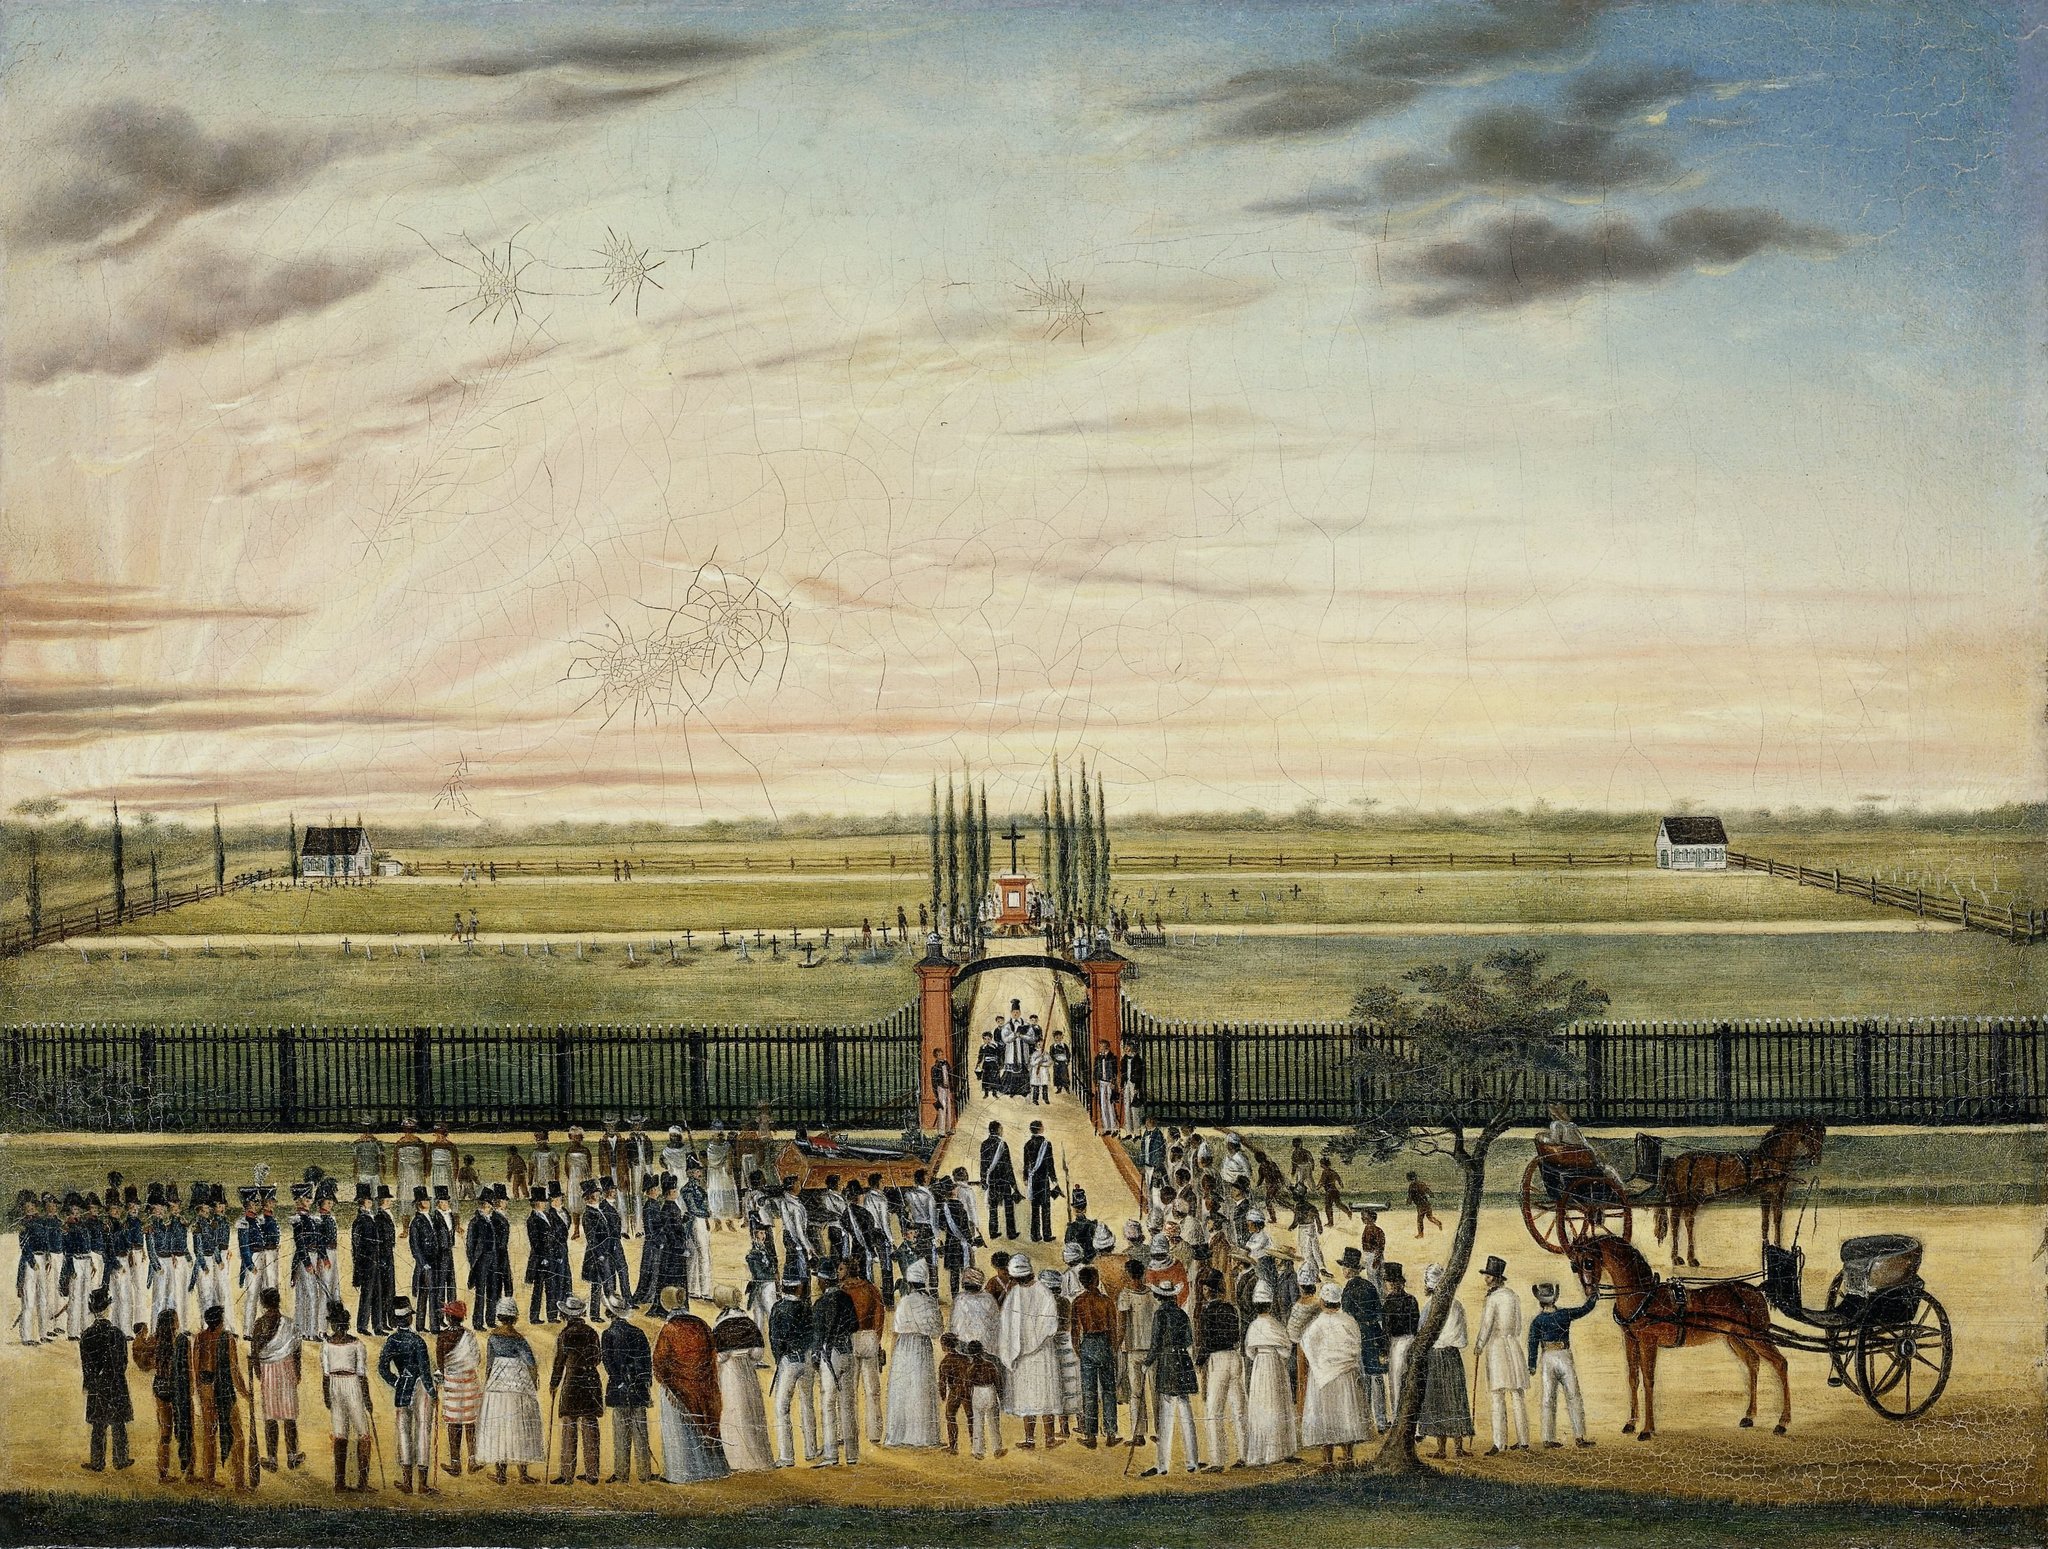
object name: painting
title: The Burial of Father Joannes Vitus Janssen (1803-43) at Paramaribo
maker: Anonymous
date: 1843-1845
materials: canvas, oil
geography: northern netherlands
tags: priest, batavia, missionary, amsterdam, cortege, funeral procession, public funeral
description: Funeral in Paramaribo of the missionary Joannes Vitus Janssen, 1843. Anonymous, c. 1843. The coffin is borne by twelve black pall bearers dressed in white to symbolise mourning. Two priests walk behind the coffin: Petrus Donders, known as the 'apostle of the Indians and lepers of Surinam', and T. Kempkes. They are followed by the church councillors, the governor's staff and various officers. Around 1,400 black Surinamers, all Catholic converts, attended the funeral. In the foreground, left, is an Indian family. Preceding the coffin are the funeral directors, members of the Kreps family. Their surname became a byword for a gravedigger in Surinam.The Catholic cemetery was opened in 1840. Slaves were buried in a separate section, probably at the back, to the left.